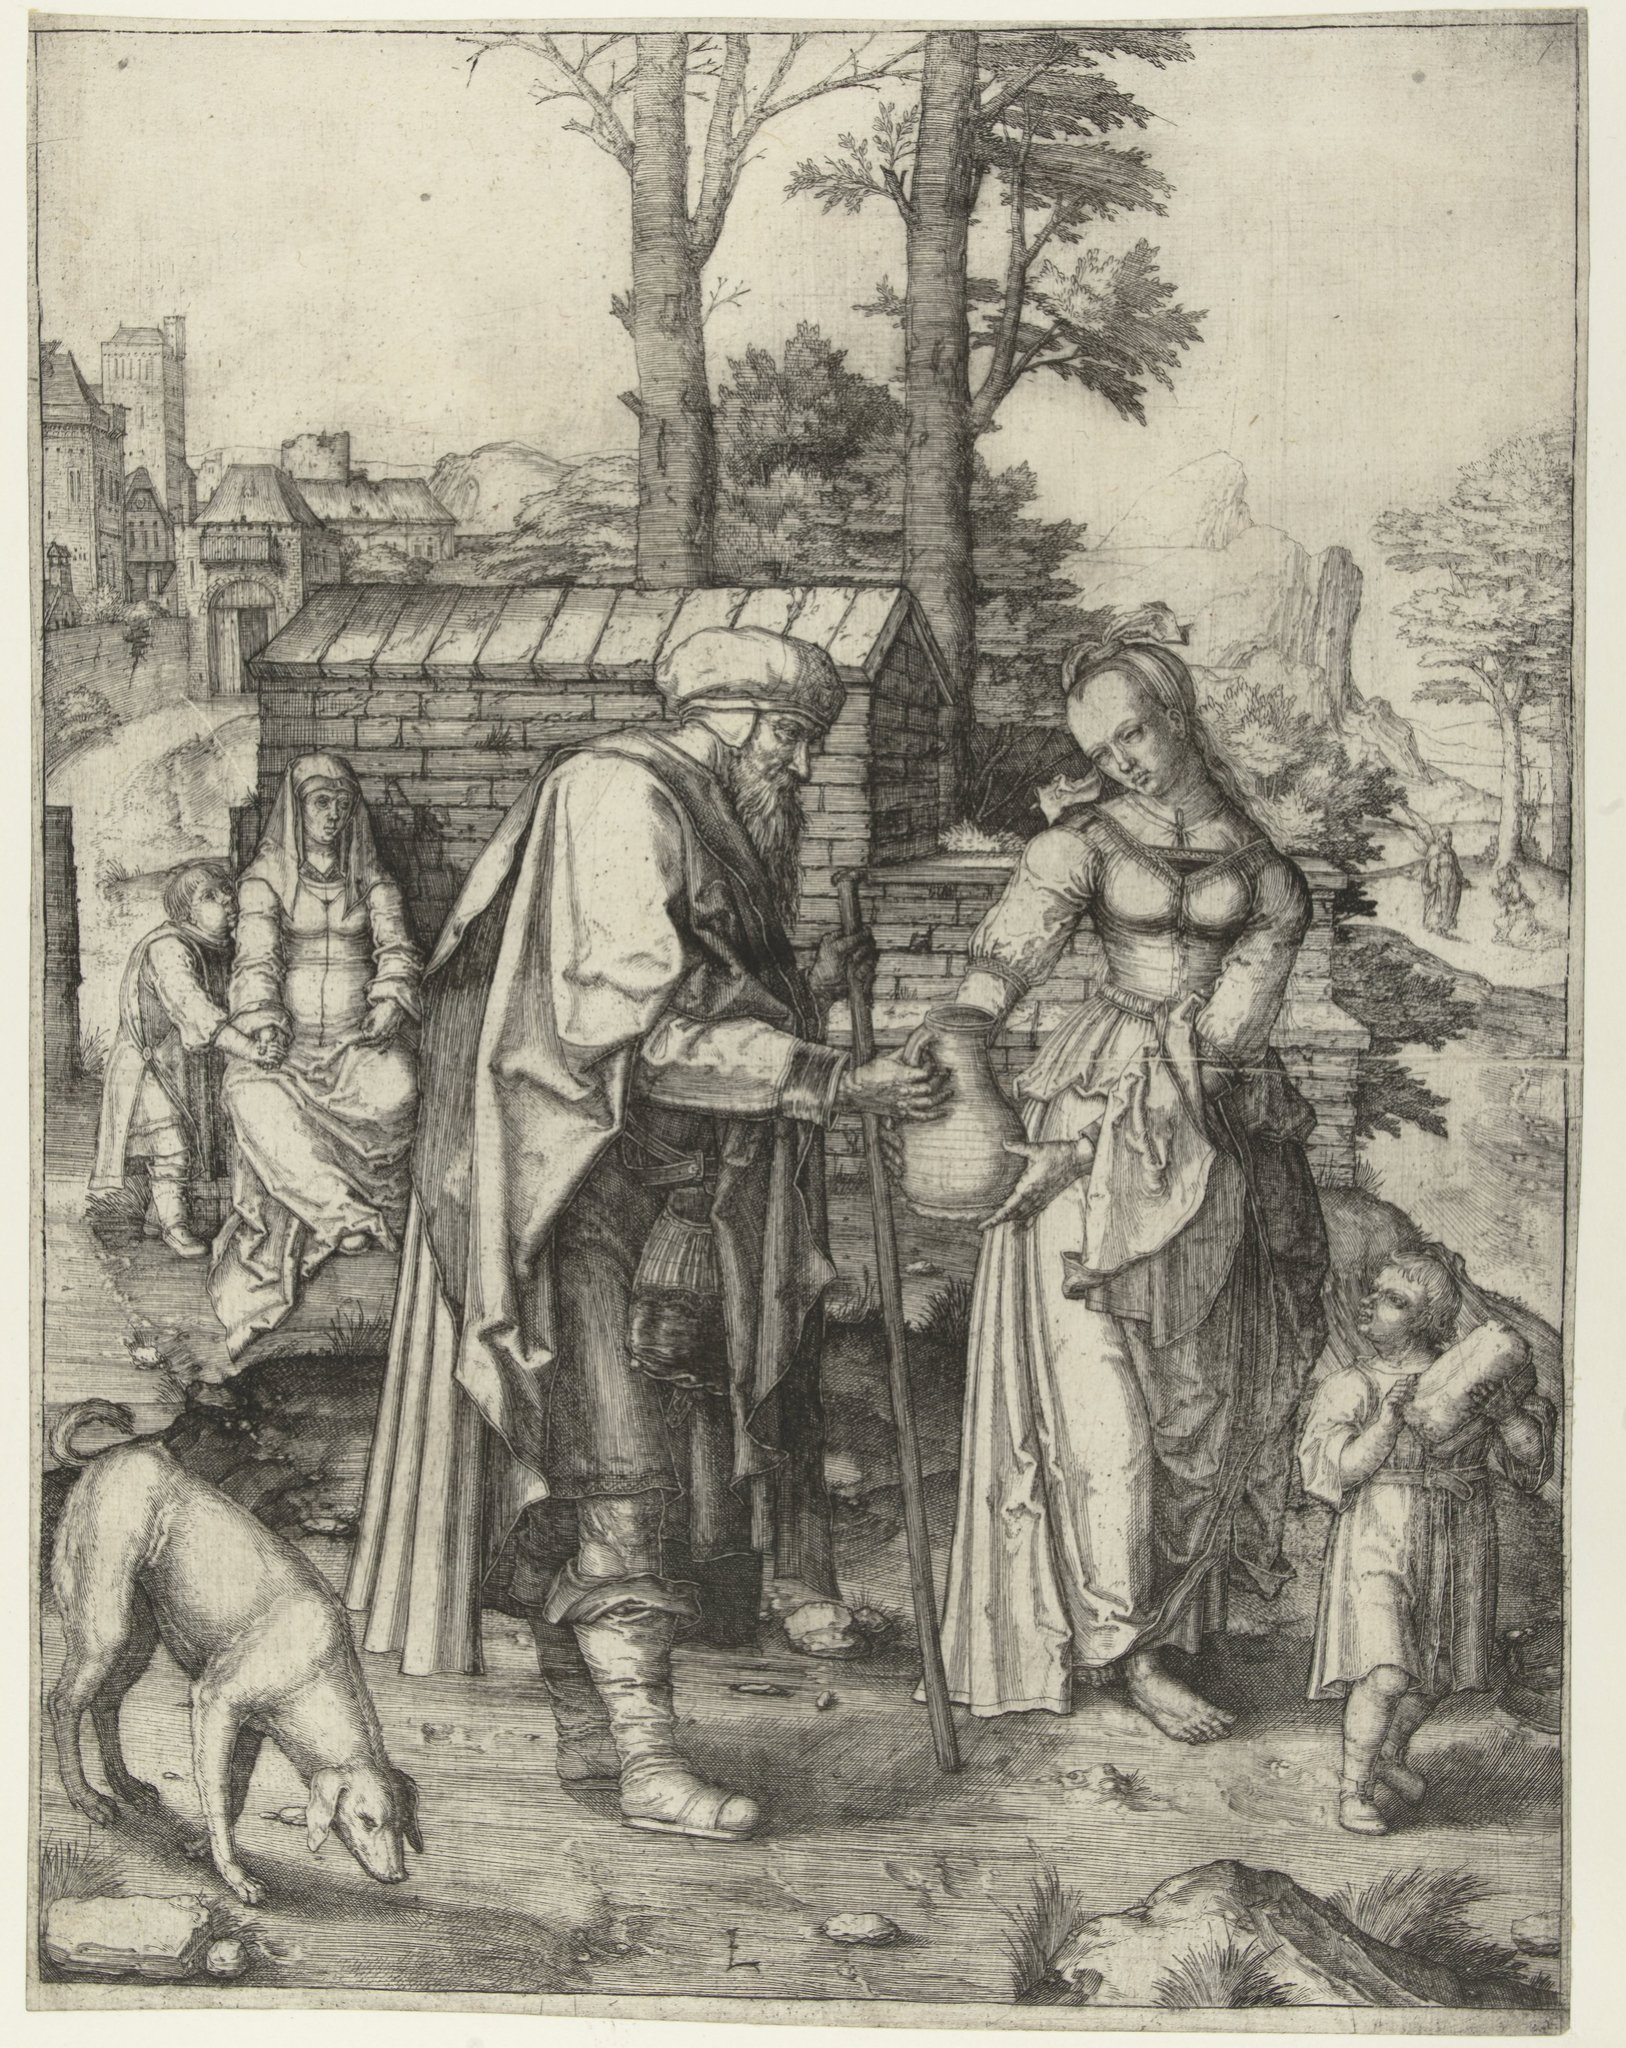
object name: print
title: Abraham verstoot Hagar en Ismaël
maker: lucas van leyden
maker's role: draughtsman, painter, print maker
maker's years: 1494-1533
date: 1505-1510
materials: paper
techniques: engraving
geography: low countries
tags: abraham provides hagar and ishmael with bread and a jug of water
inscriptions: signature: ‘L’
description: Abraham geeft een kruik aan Hagar, die vertrekt met hun zoon Ismaël. Achter Abraham zit Sarah tegen een muur met Isaak. In het landschap op de achtergrond een engel die aan Hagar verschijnt.